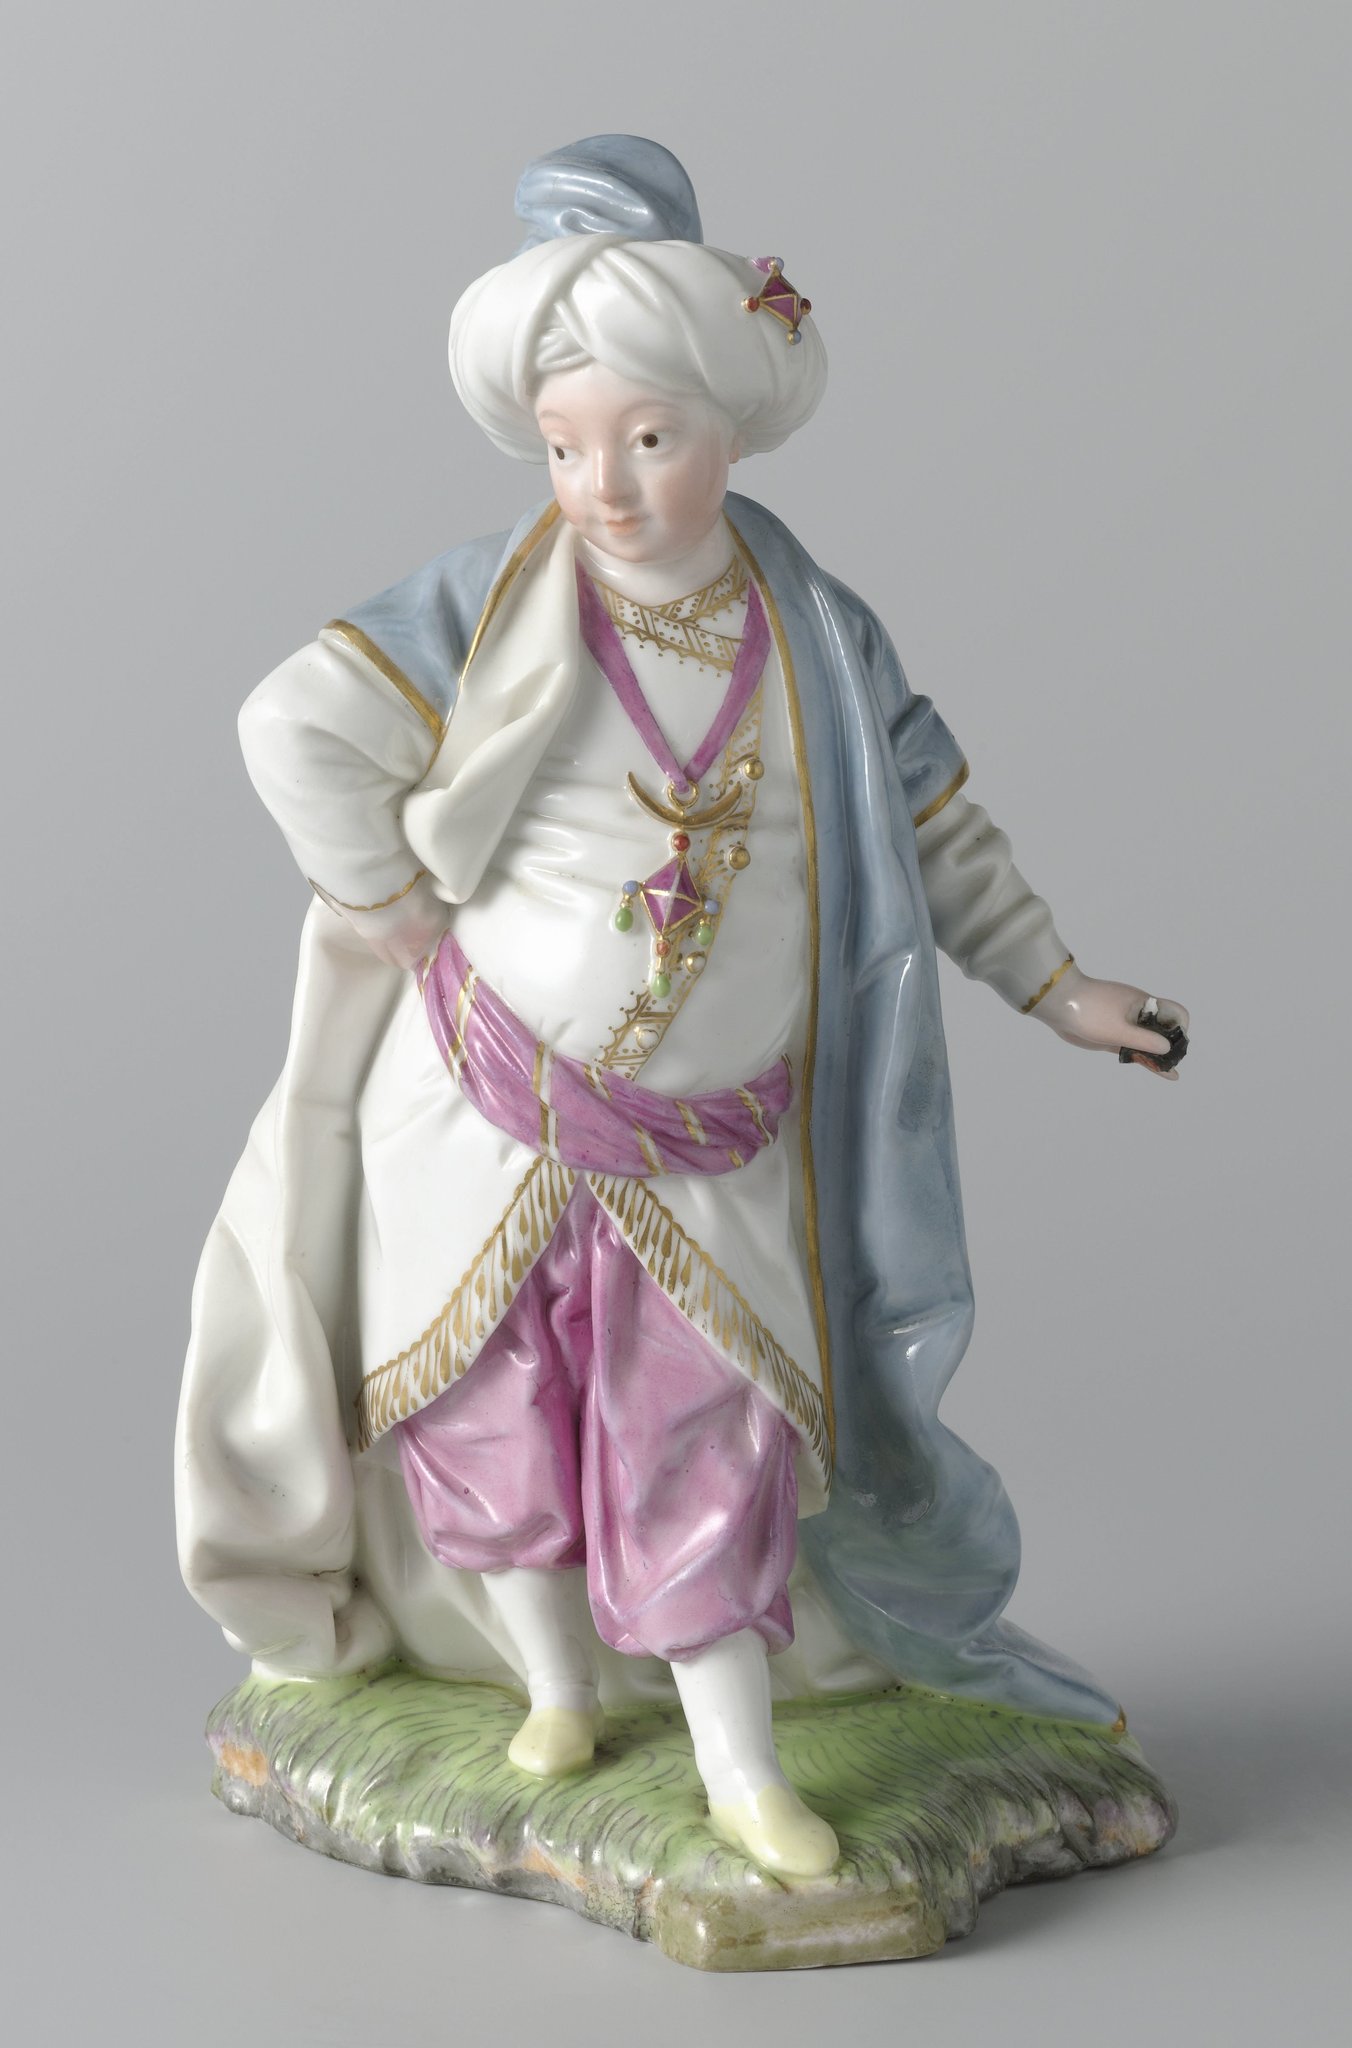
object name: figure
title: Boy and Girl in Oriental Dress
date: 1767-1775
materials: glaze, gold, paint, porcelain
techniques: firing, forming, gilding, vitrification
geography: höchst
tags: boy (child between toddler and youth), head-gear: turban, folk costume, regional costume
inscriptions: mark: ‘wiel met keurvorstenhoed/ HM’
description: Höchster Porzellanmanufaktur modelled by Johann Peter Melchior (1747–1825) Höchst, c. 1767–1775 hard-paste porcelain